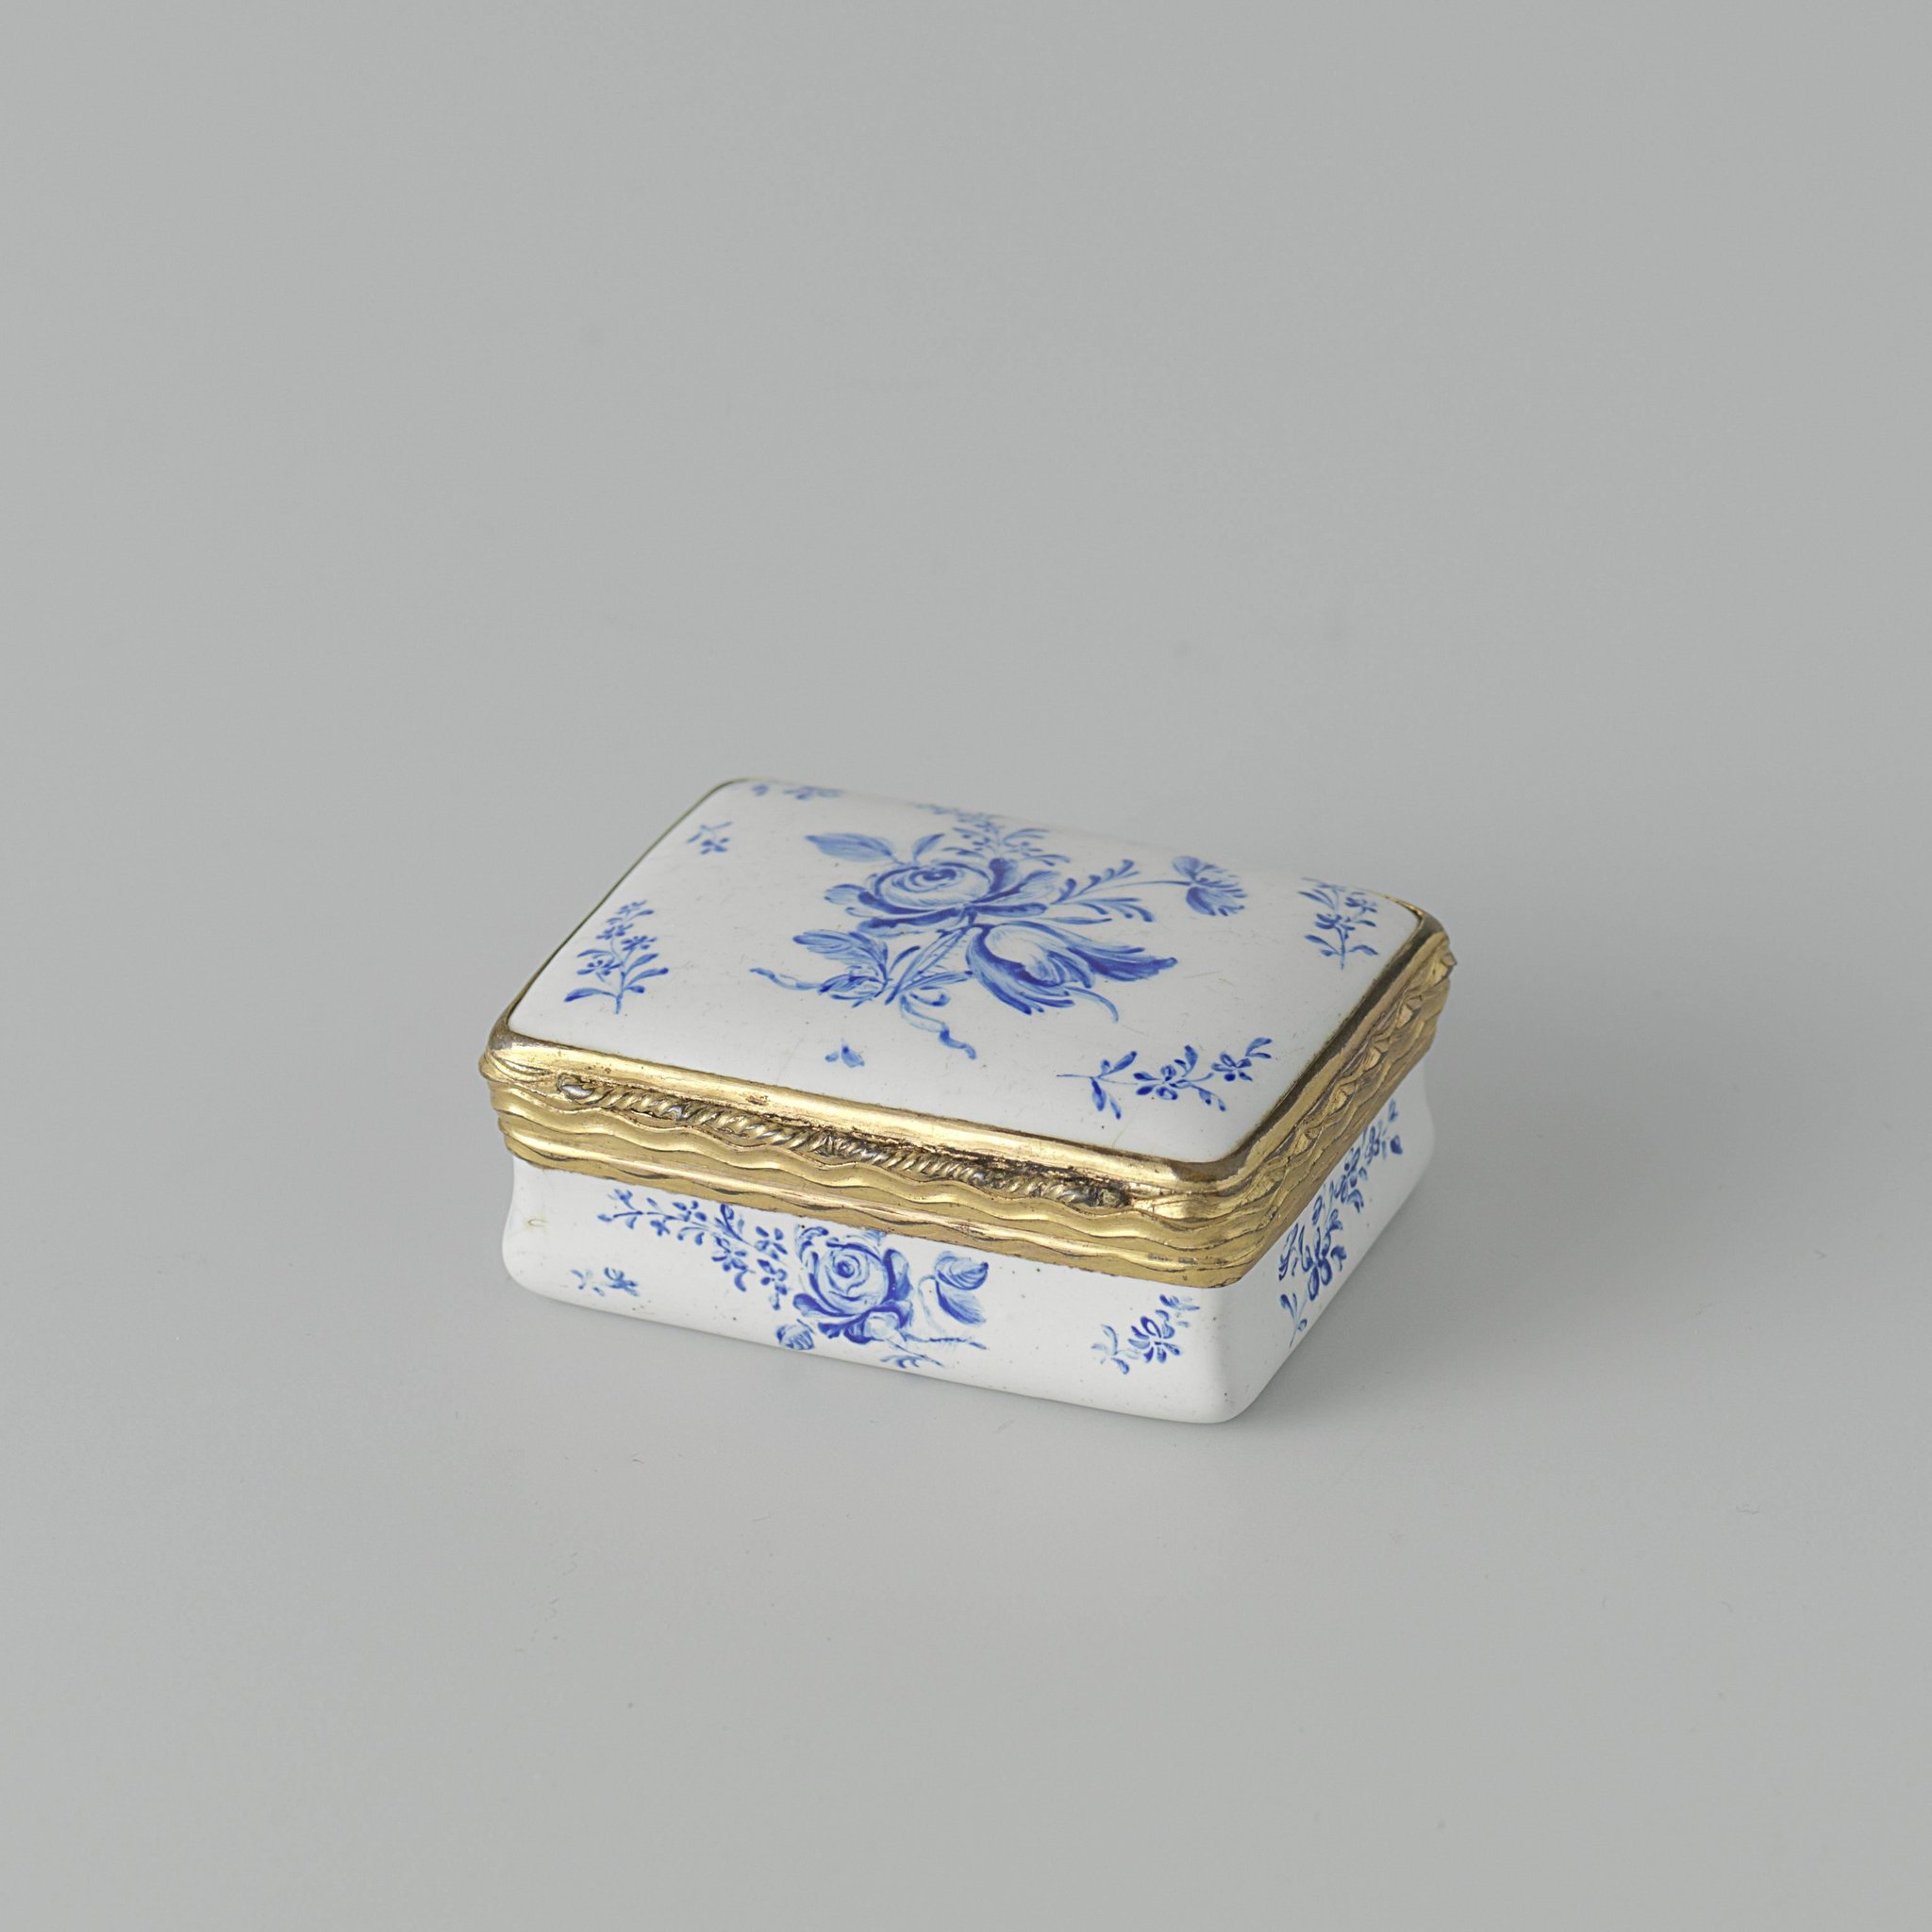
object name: box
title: Snuffbox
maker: Anonymous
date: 1800-1900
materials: copper, porcelain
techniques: gilding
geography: battersea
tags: flowers ~ ornament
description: Snuifdoos van verguld koper met wit émail met blauwe bloemen. De doos heeft een dubbele deksel en een bijbehorend lepeltje.